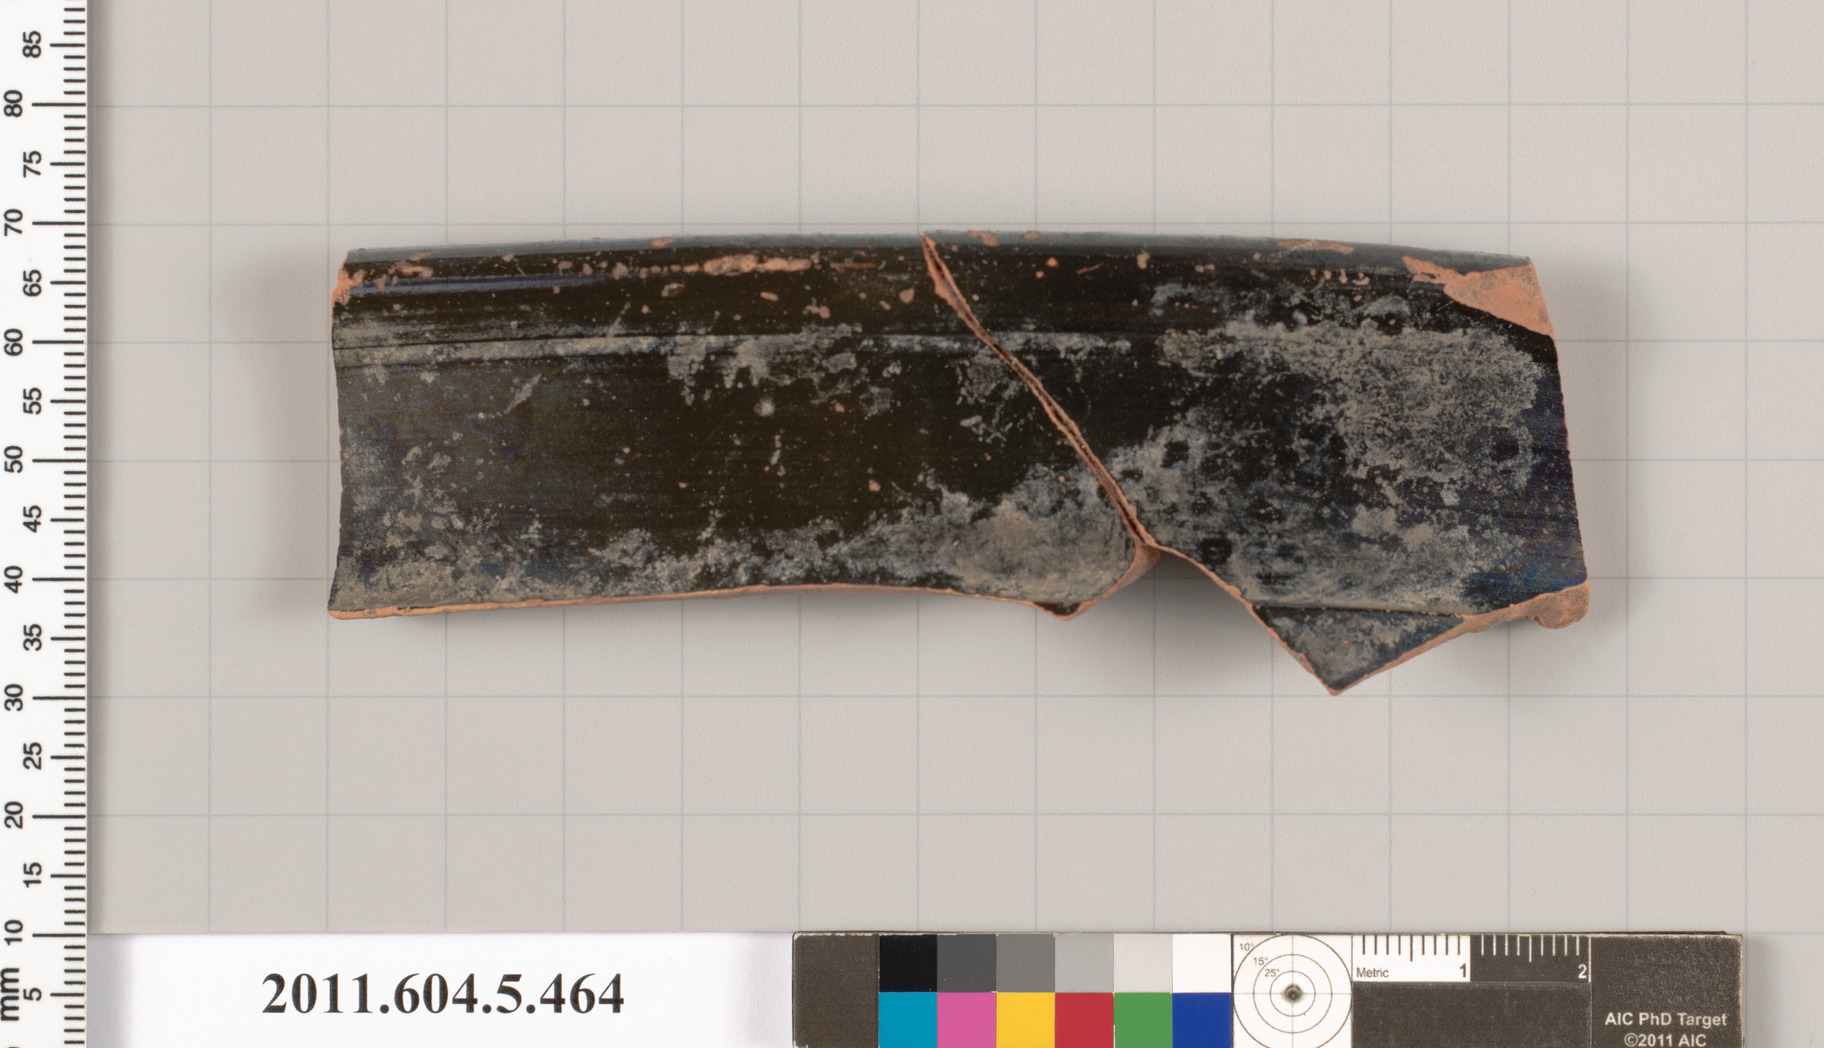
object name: kylix fragment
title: Terracotta rim fragment of a kylix (drinking cup)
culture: greek, attic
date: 600-401 BCE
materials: terracotta